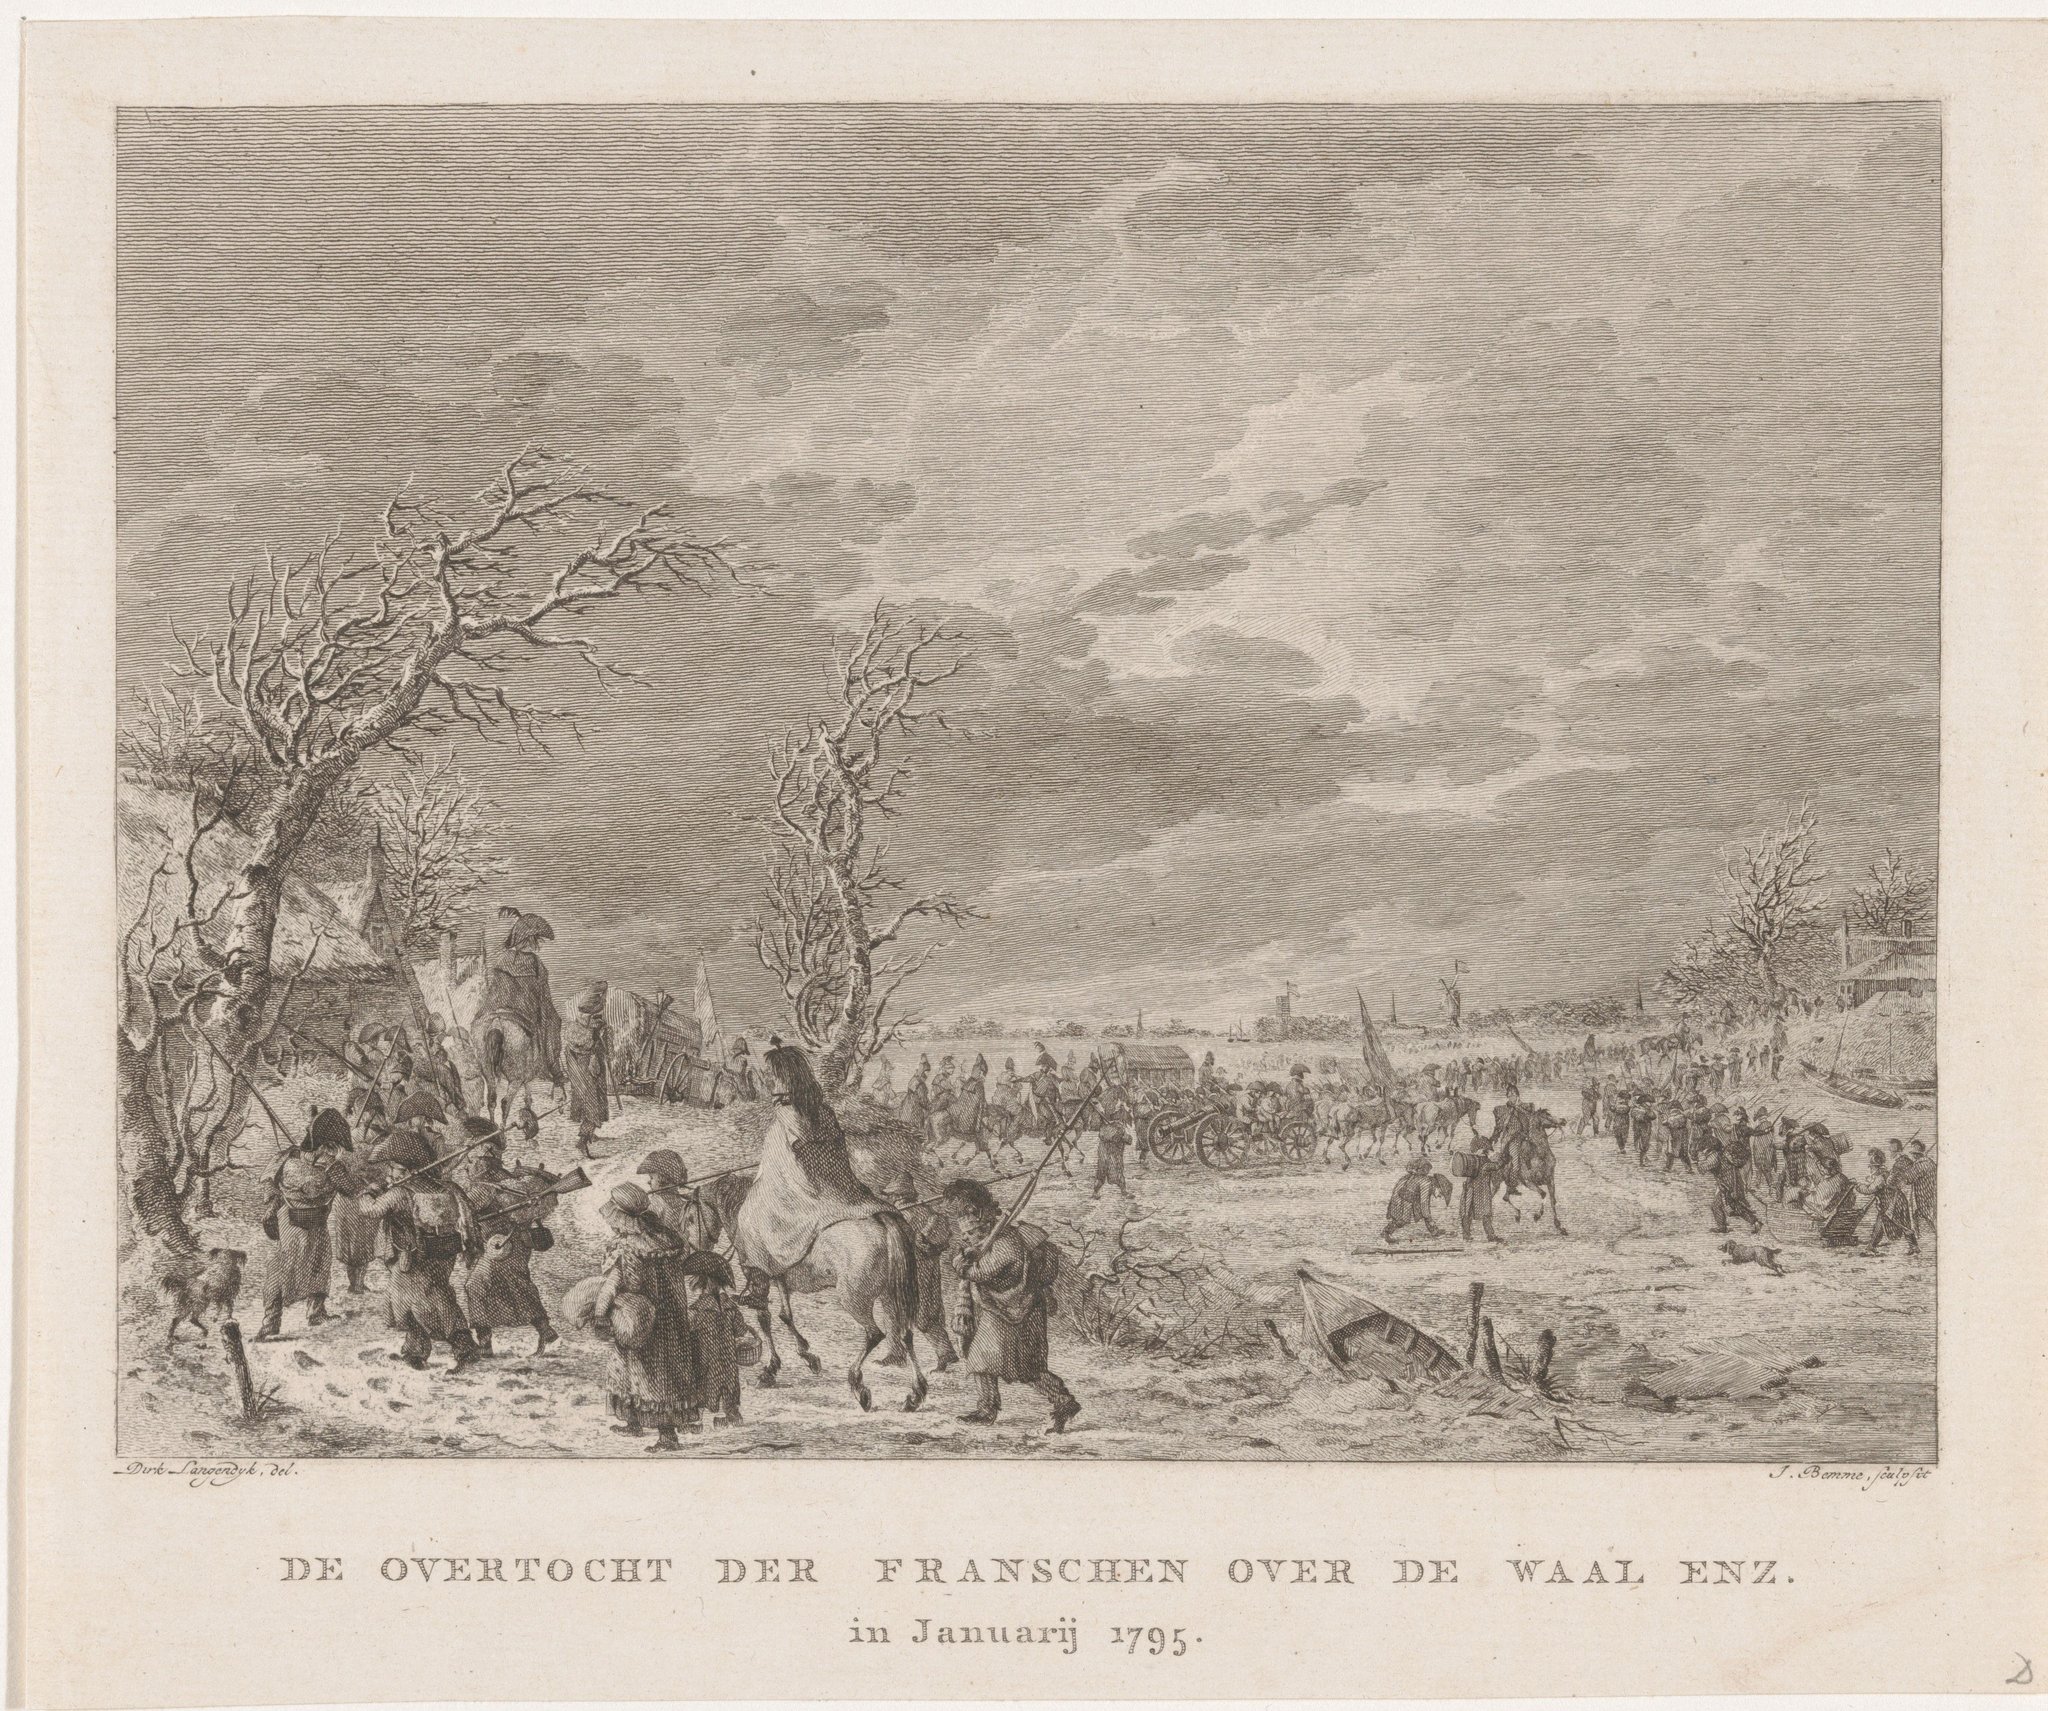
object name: print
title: De overtocht der Franschen over de Waal enz. in januarij 1795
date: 1795-1841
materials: paper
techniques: etching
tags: the defeated (after the battle)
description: De gehavende soldaten steken te voet en te paard de bevroren rivier over. Geschut wordt op wagens mee gevoerd.